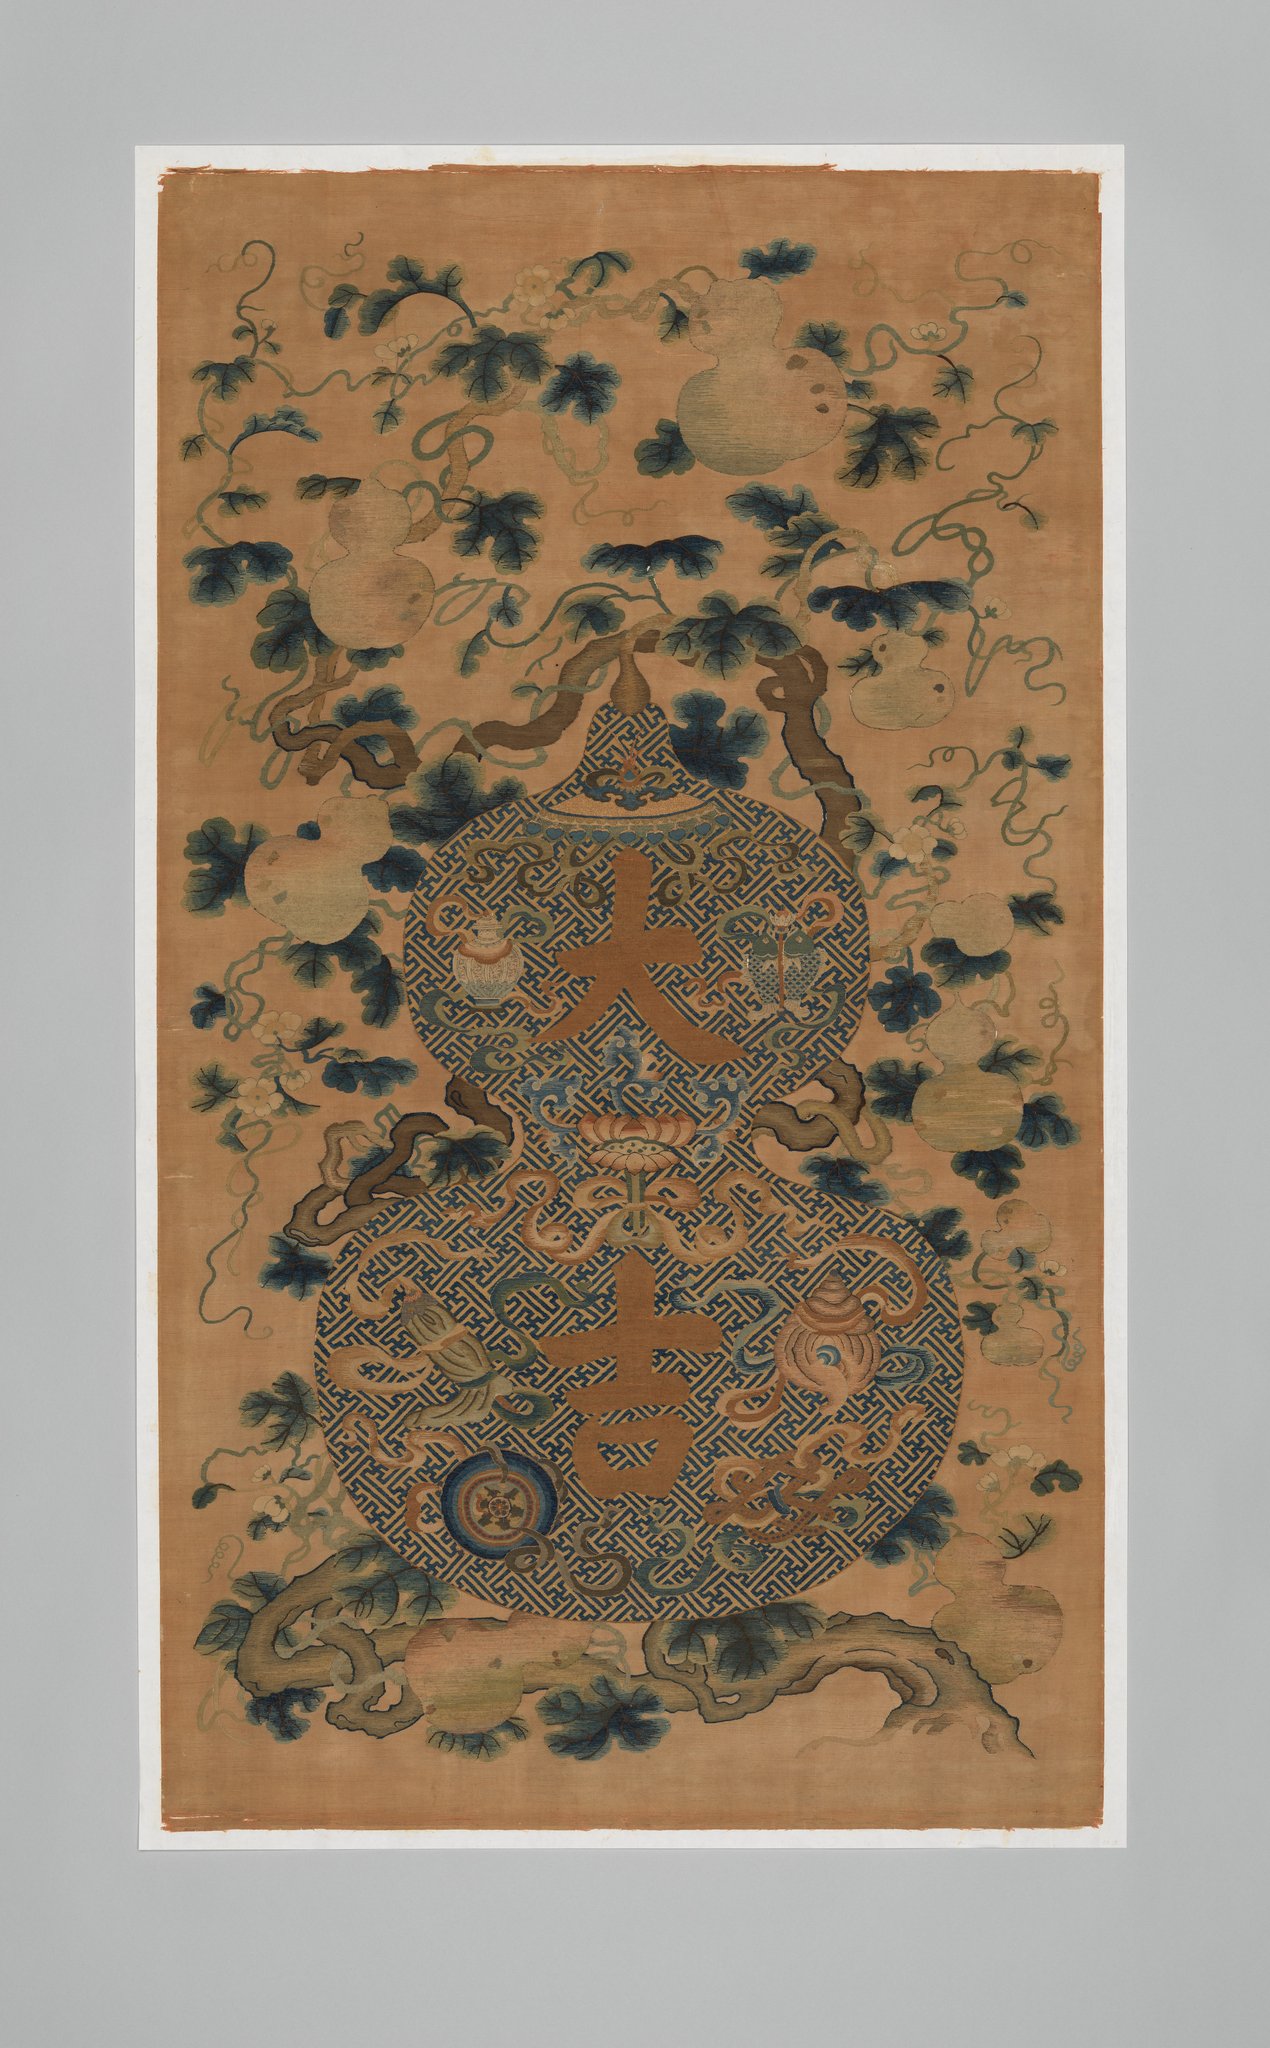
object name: panel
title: Panel with gourds on vines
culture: chinese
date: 1767-1833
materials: metal thread, silk, wool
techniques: tapestry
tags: gourds